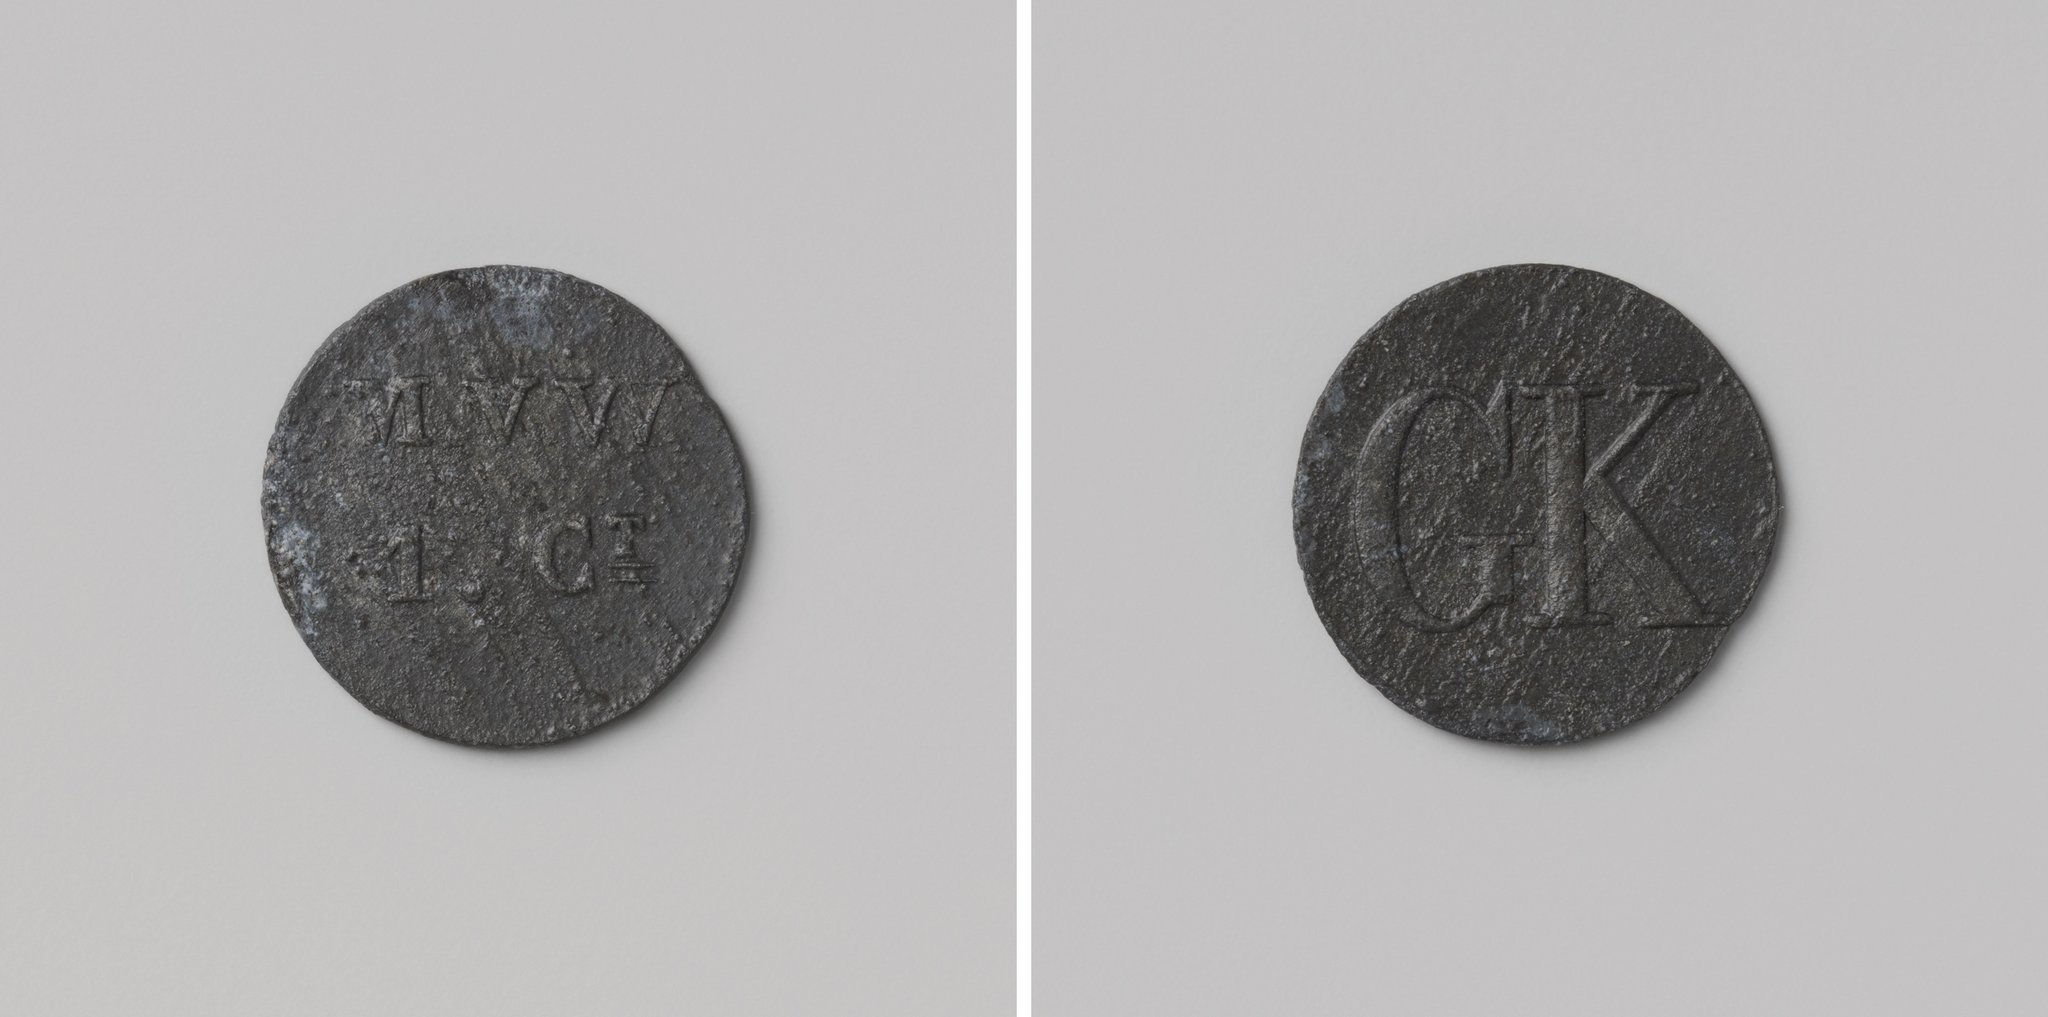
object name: cent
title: Huismunt geslagen op last van de Maatschappij van Weldadigheid ter waarde van 1 cent, ten behoeve van de Gewone Koloniën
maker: Anonymous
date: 1818-1859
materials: zinc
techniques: striking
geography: netherlands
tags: maatschappij van weldadigheid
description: Zinken munt. Voorzijde: opschrift boven waardeaanduiding. Keerzijde: opschrift G en K